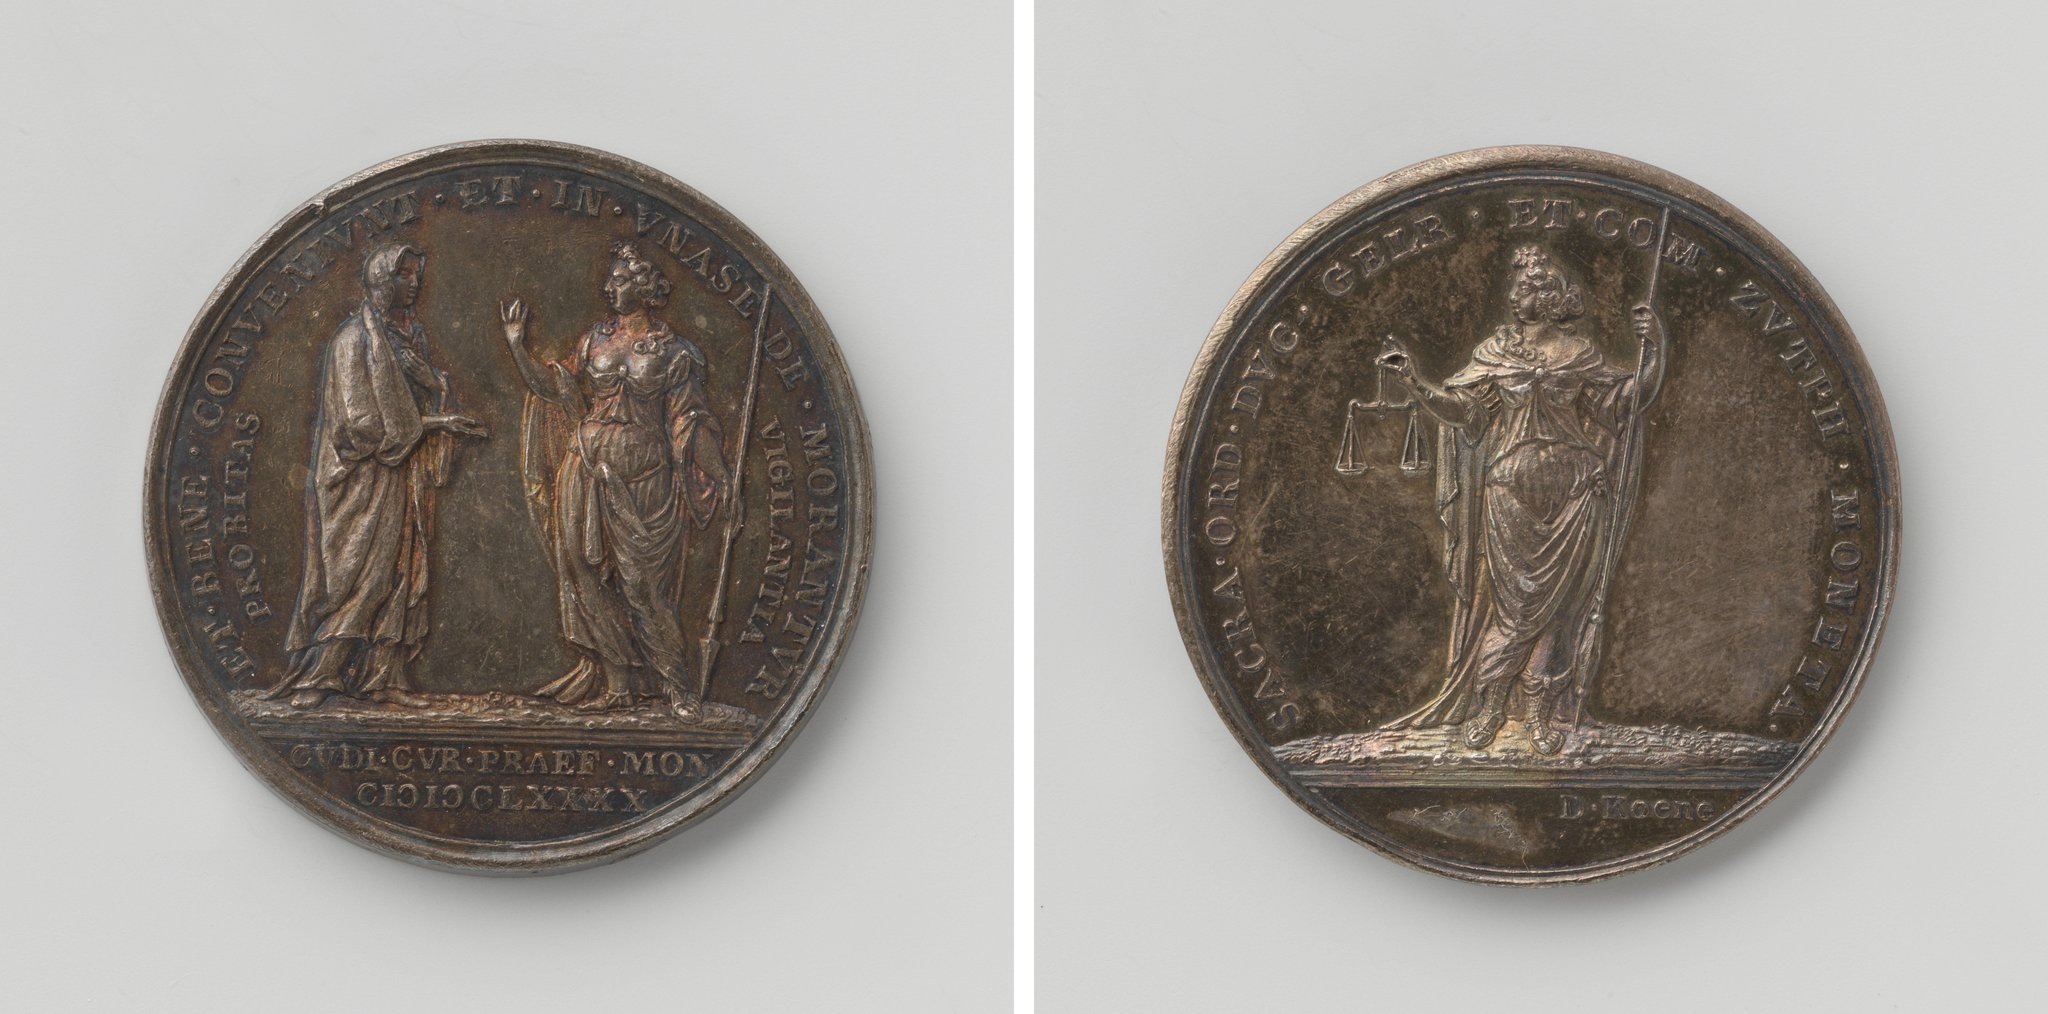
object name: history medal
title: Johann van Brienen aanvaardt het muntmeesterschap van de Gelderse munt te Harderwijk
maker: d. koene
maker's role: die cutter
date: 1690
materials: silver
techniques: striking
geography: dordrecht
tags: gelderland